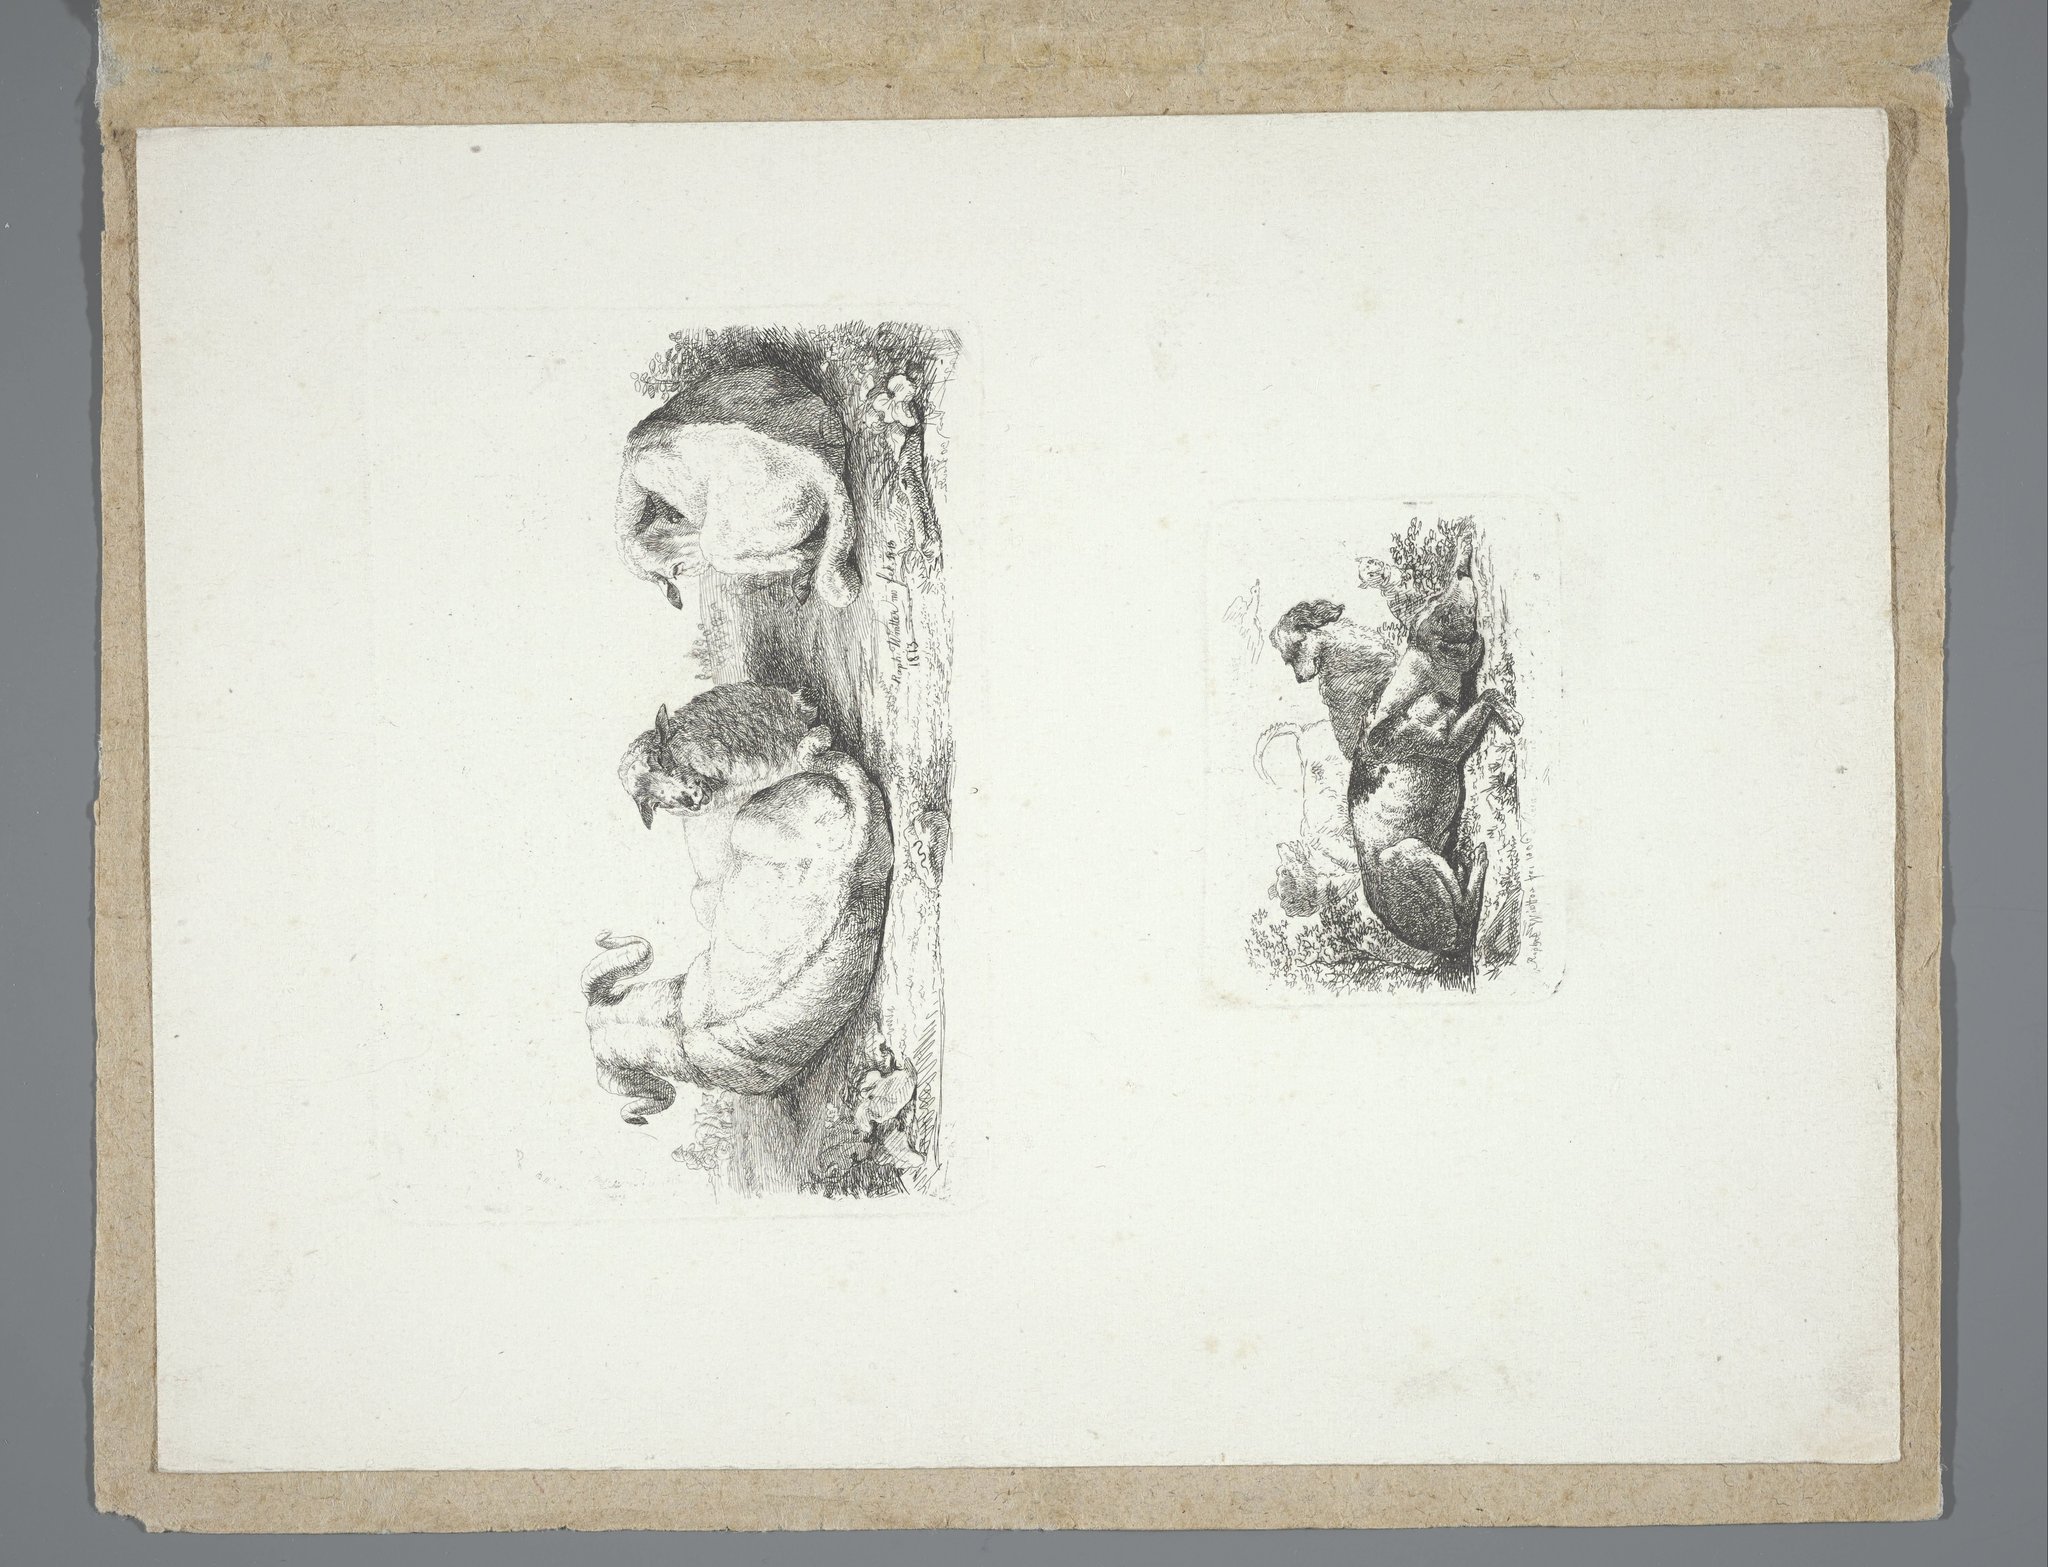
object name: print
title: Blad met twee voorstellingen: boven drie liggende schapen en een onder een viertal honden.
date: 1806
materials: paper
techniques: etching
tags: sheep, dog